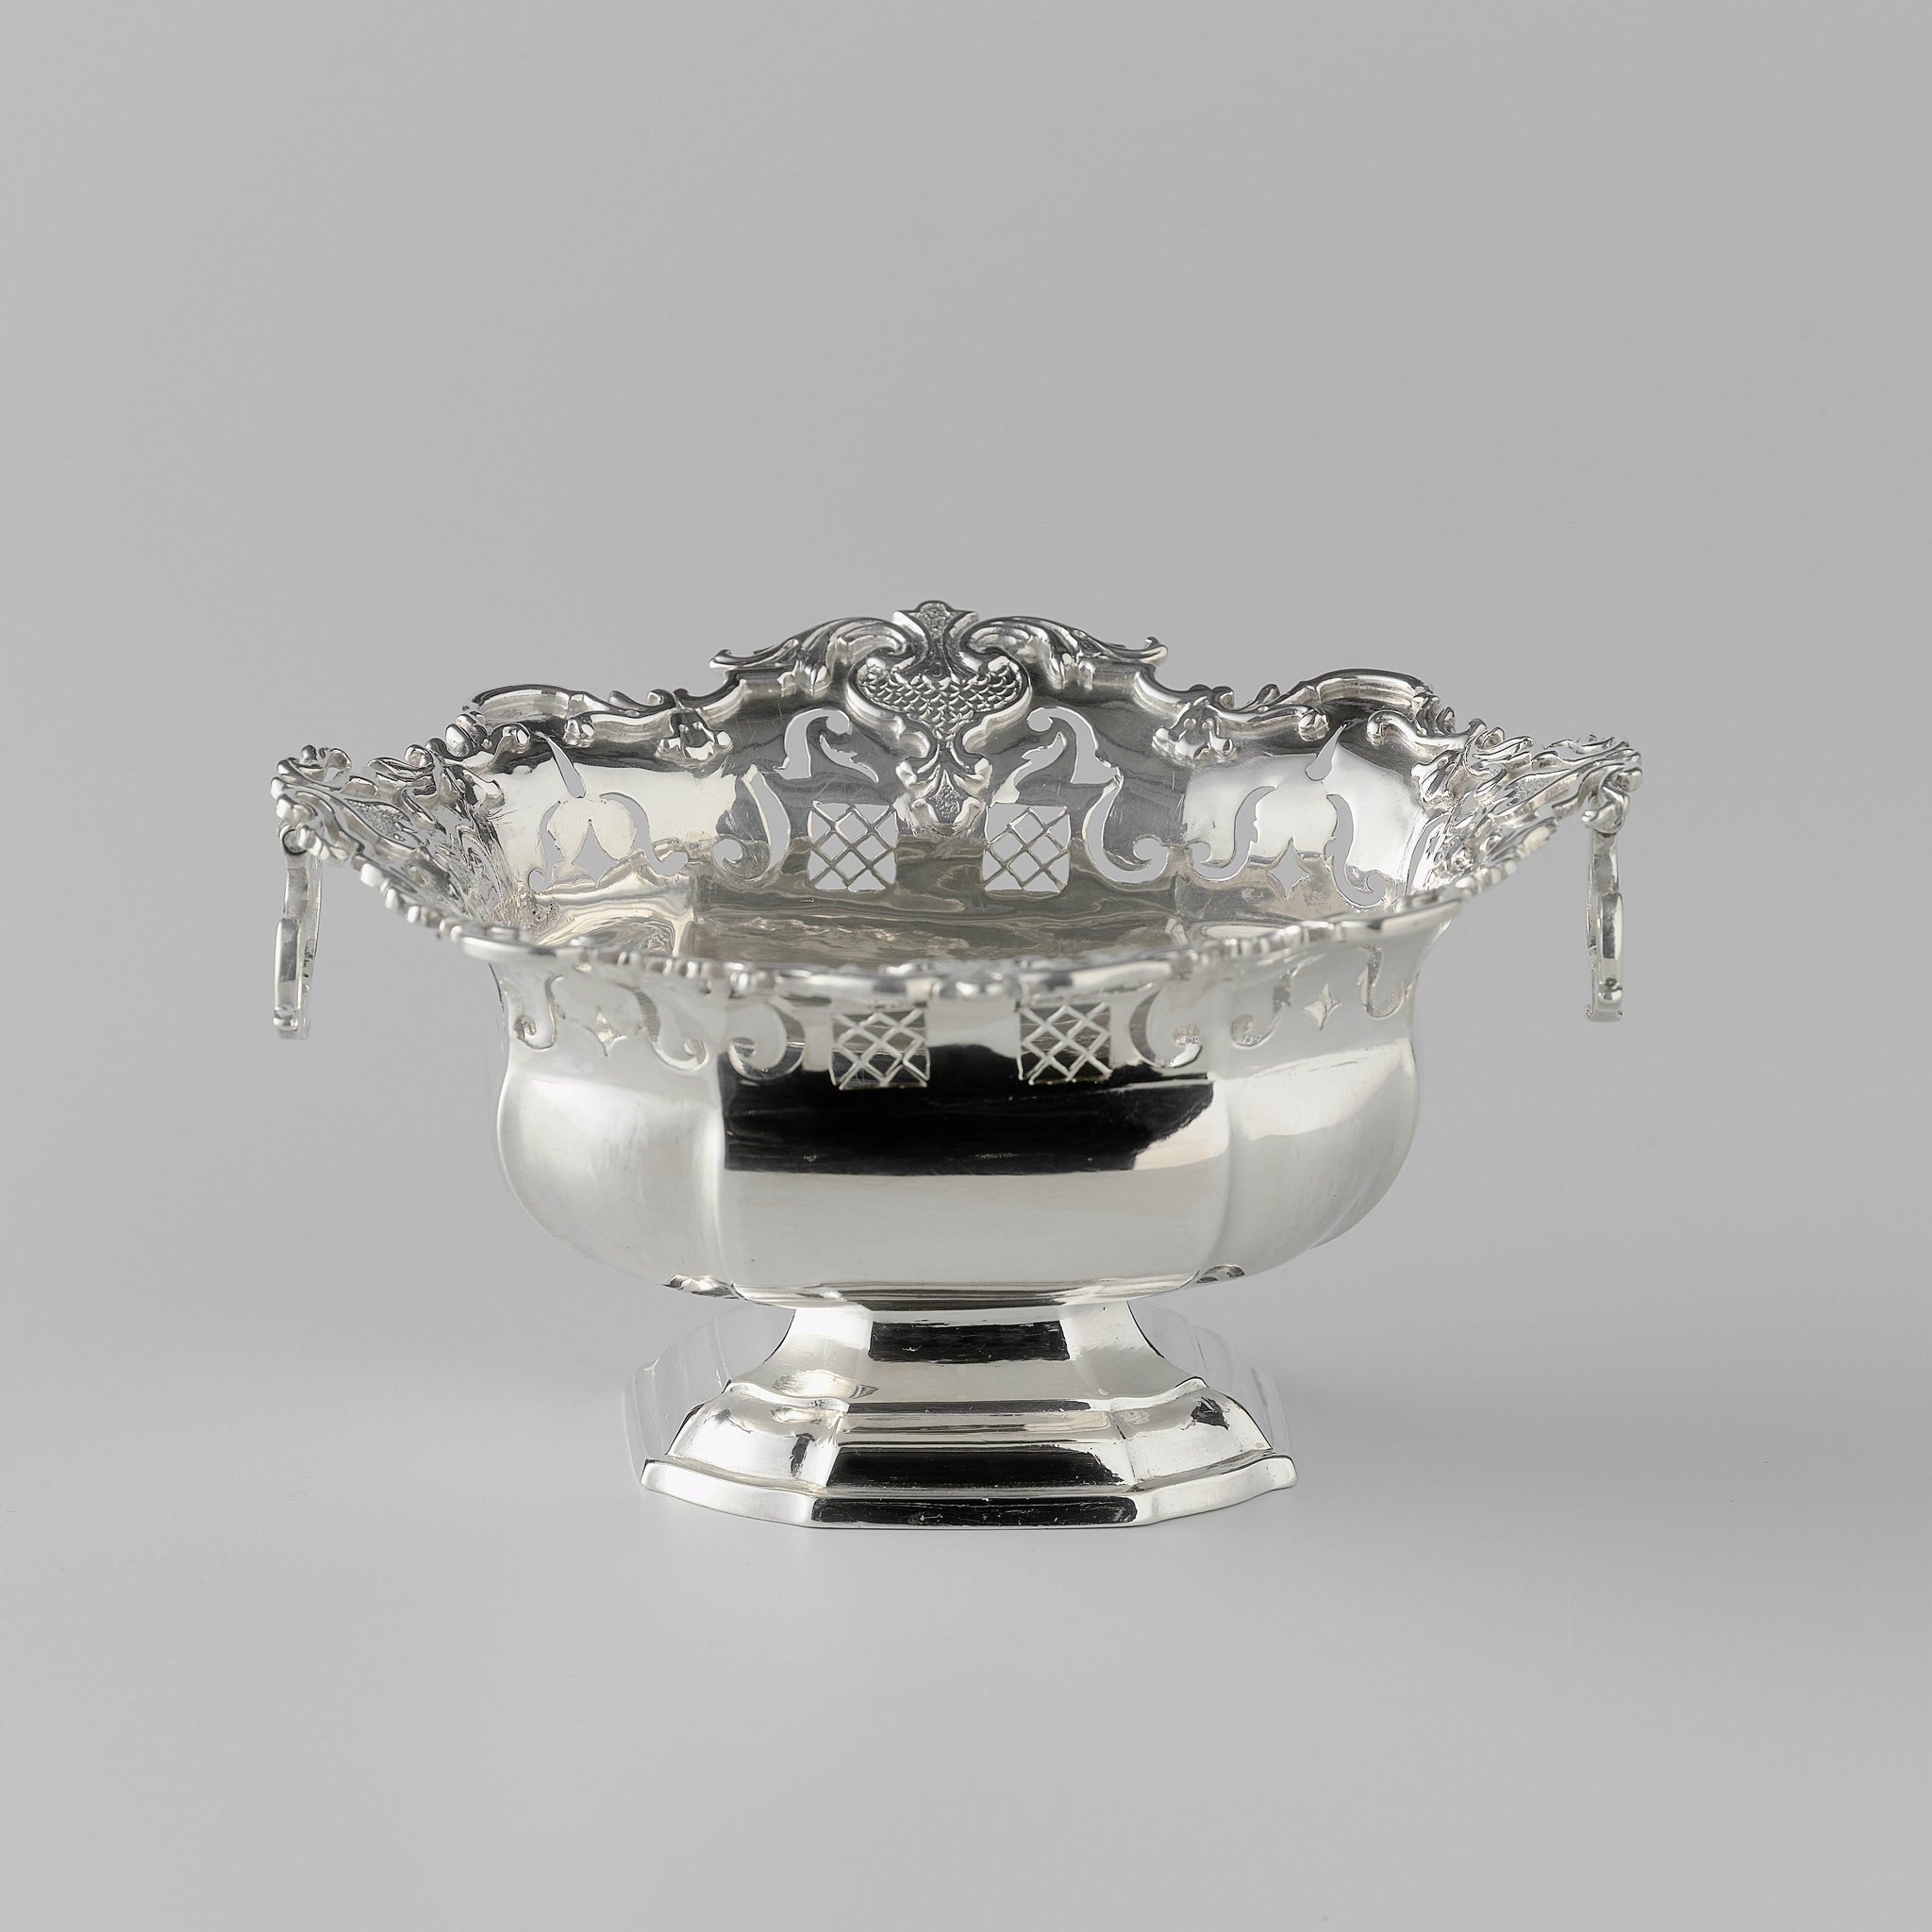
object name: kandijbak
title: Kandijbak in de vorm van een koelvat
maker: Anonymous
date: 1744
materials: silver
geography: rotterdam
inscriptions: mark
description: Sweetmeat basket. Silver. Rotterdam, 1744, maker's mark a deer leaping.